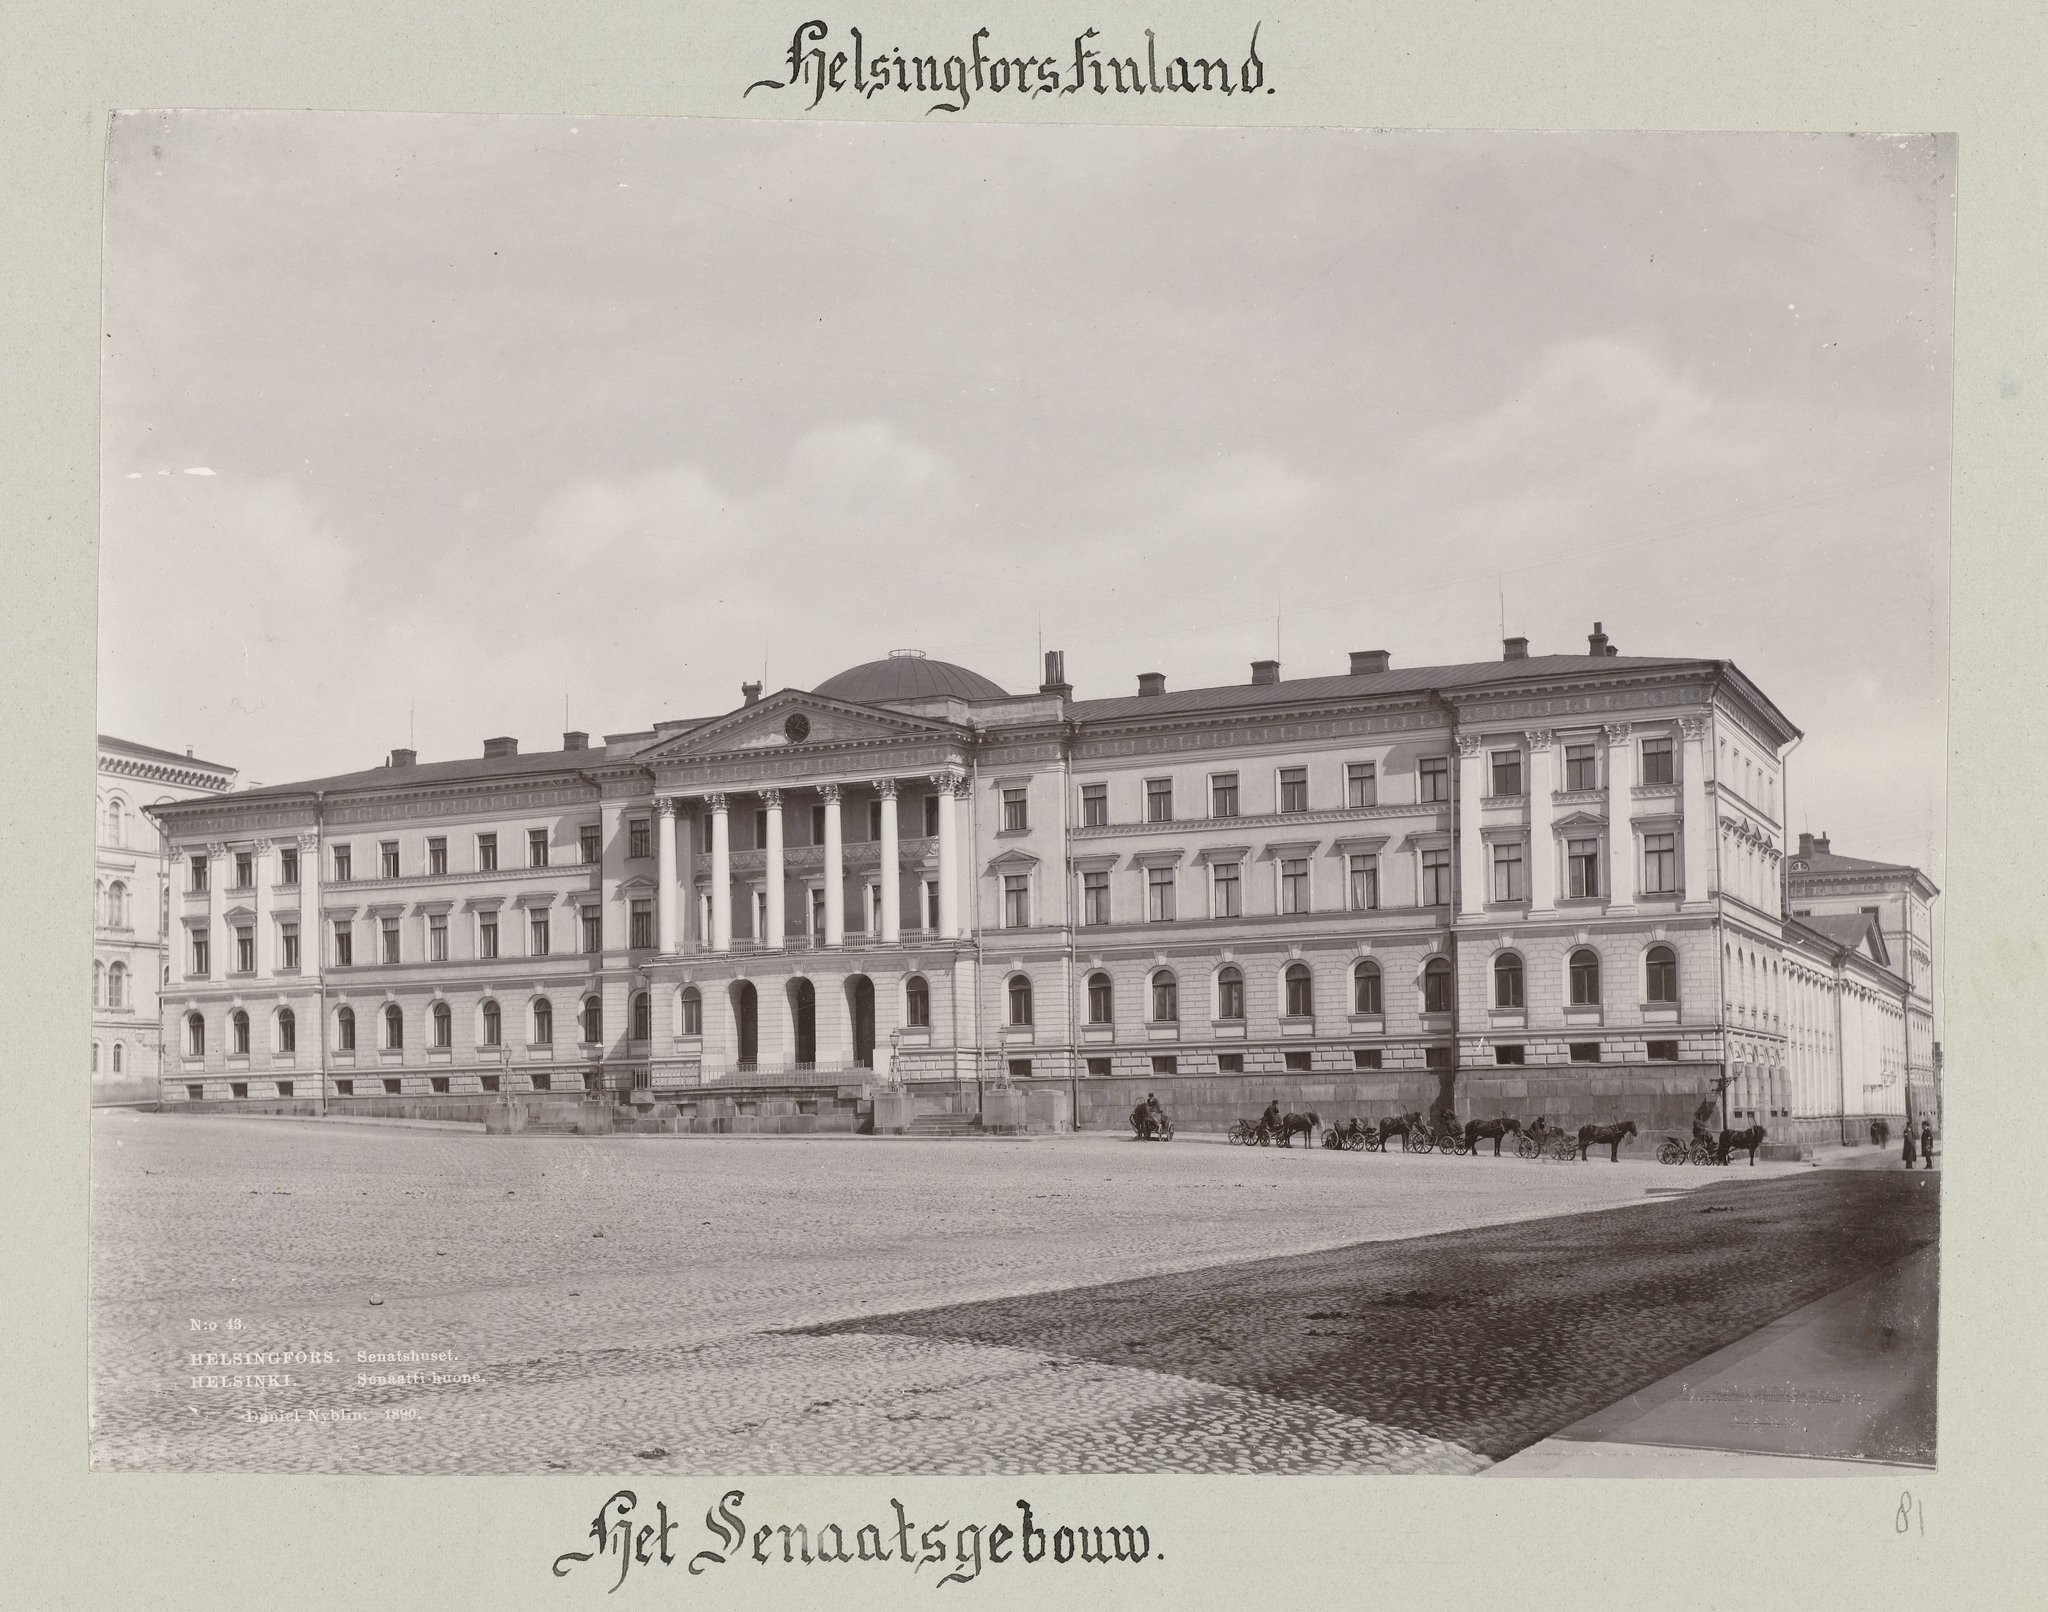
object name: photograph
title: No 43 Helsingfors Senatshuset Daniel Nyblin 1890.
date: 1898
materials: paper, photographic support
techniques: albumen print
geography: netherlands